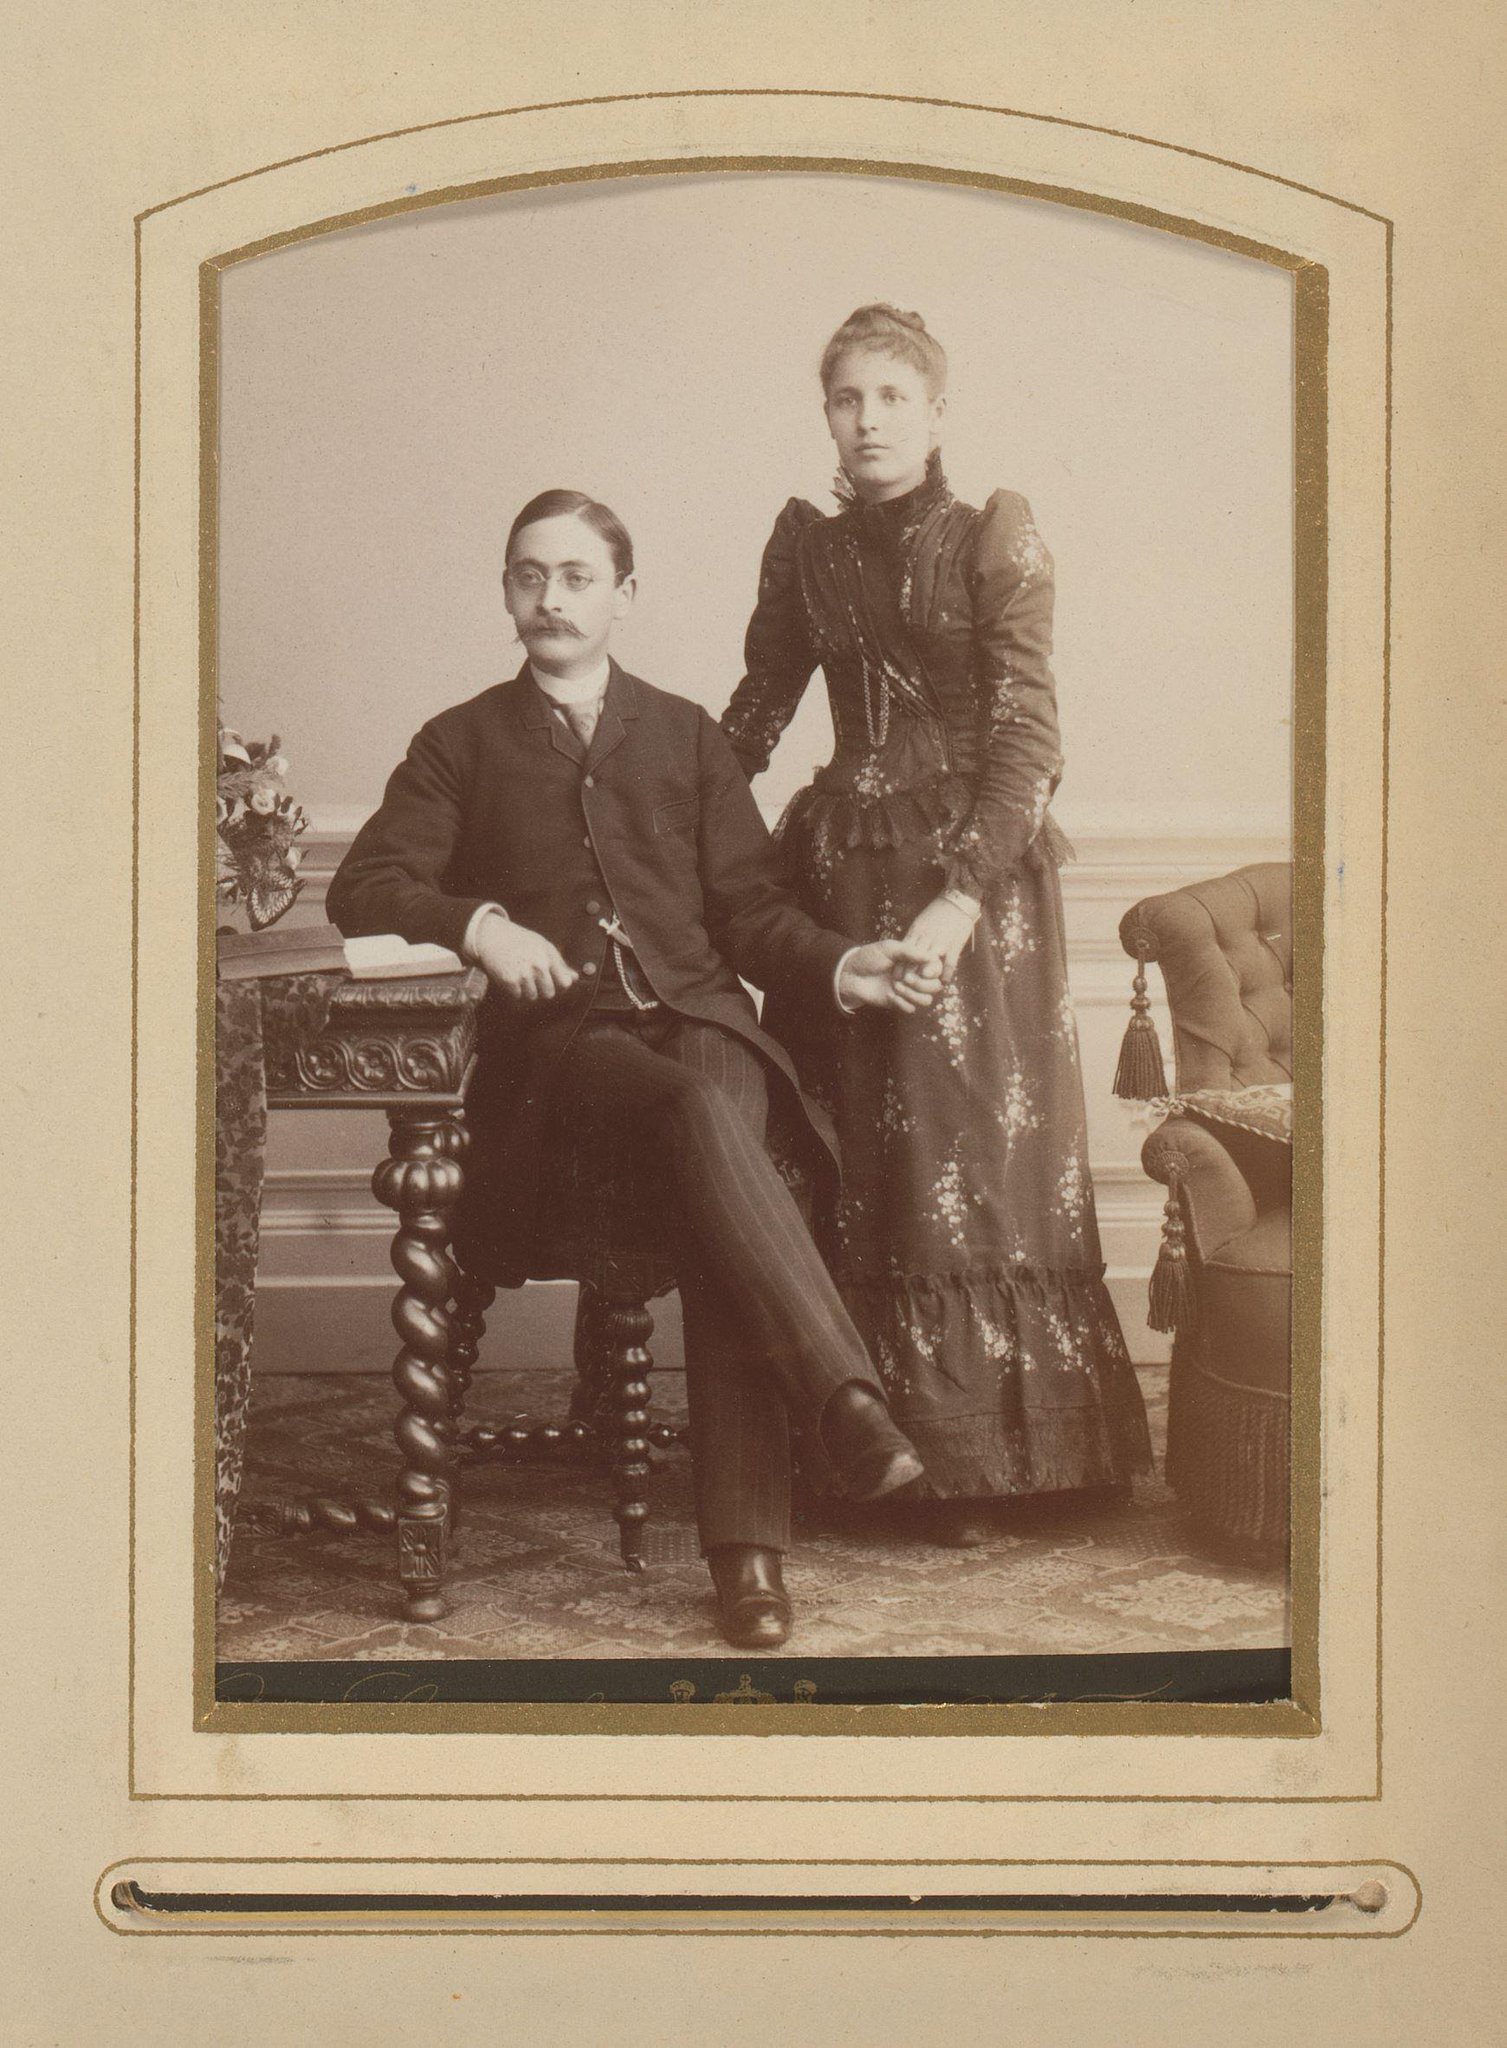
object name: photograph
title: Portret van een echtpaar, de man zittend en de vrouw staand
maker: oscar strensch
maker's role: fotograaf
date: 1887-1900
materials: cardboard, photographic support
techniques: albumen print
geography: barmen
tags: historical persons - bb - woman, historical persons, marriage, married couple, 'matrimonium'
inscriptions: inscription: ‘Oscar Strensch/ Hof-Photograph/ Sr. Majestät/ d. Kaisers u. Königs./ Wittenberg/ 14 Markt 14,/ am Rathhause./ Preisgekrönt:/ Wittenberg/ Wien/ Leipzig/ Zürich./ Die Platte bleibt für Nachbestellung aufbewahrt.’